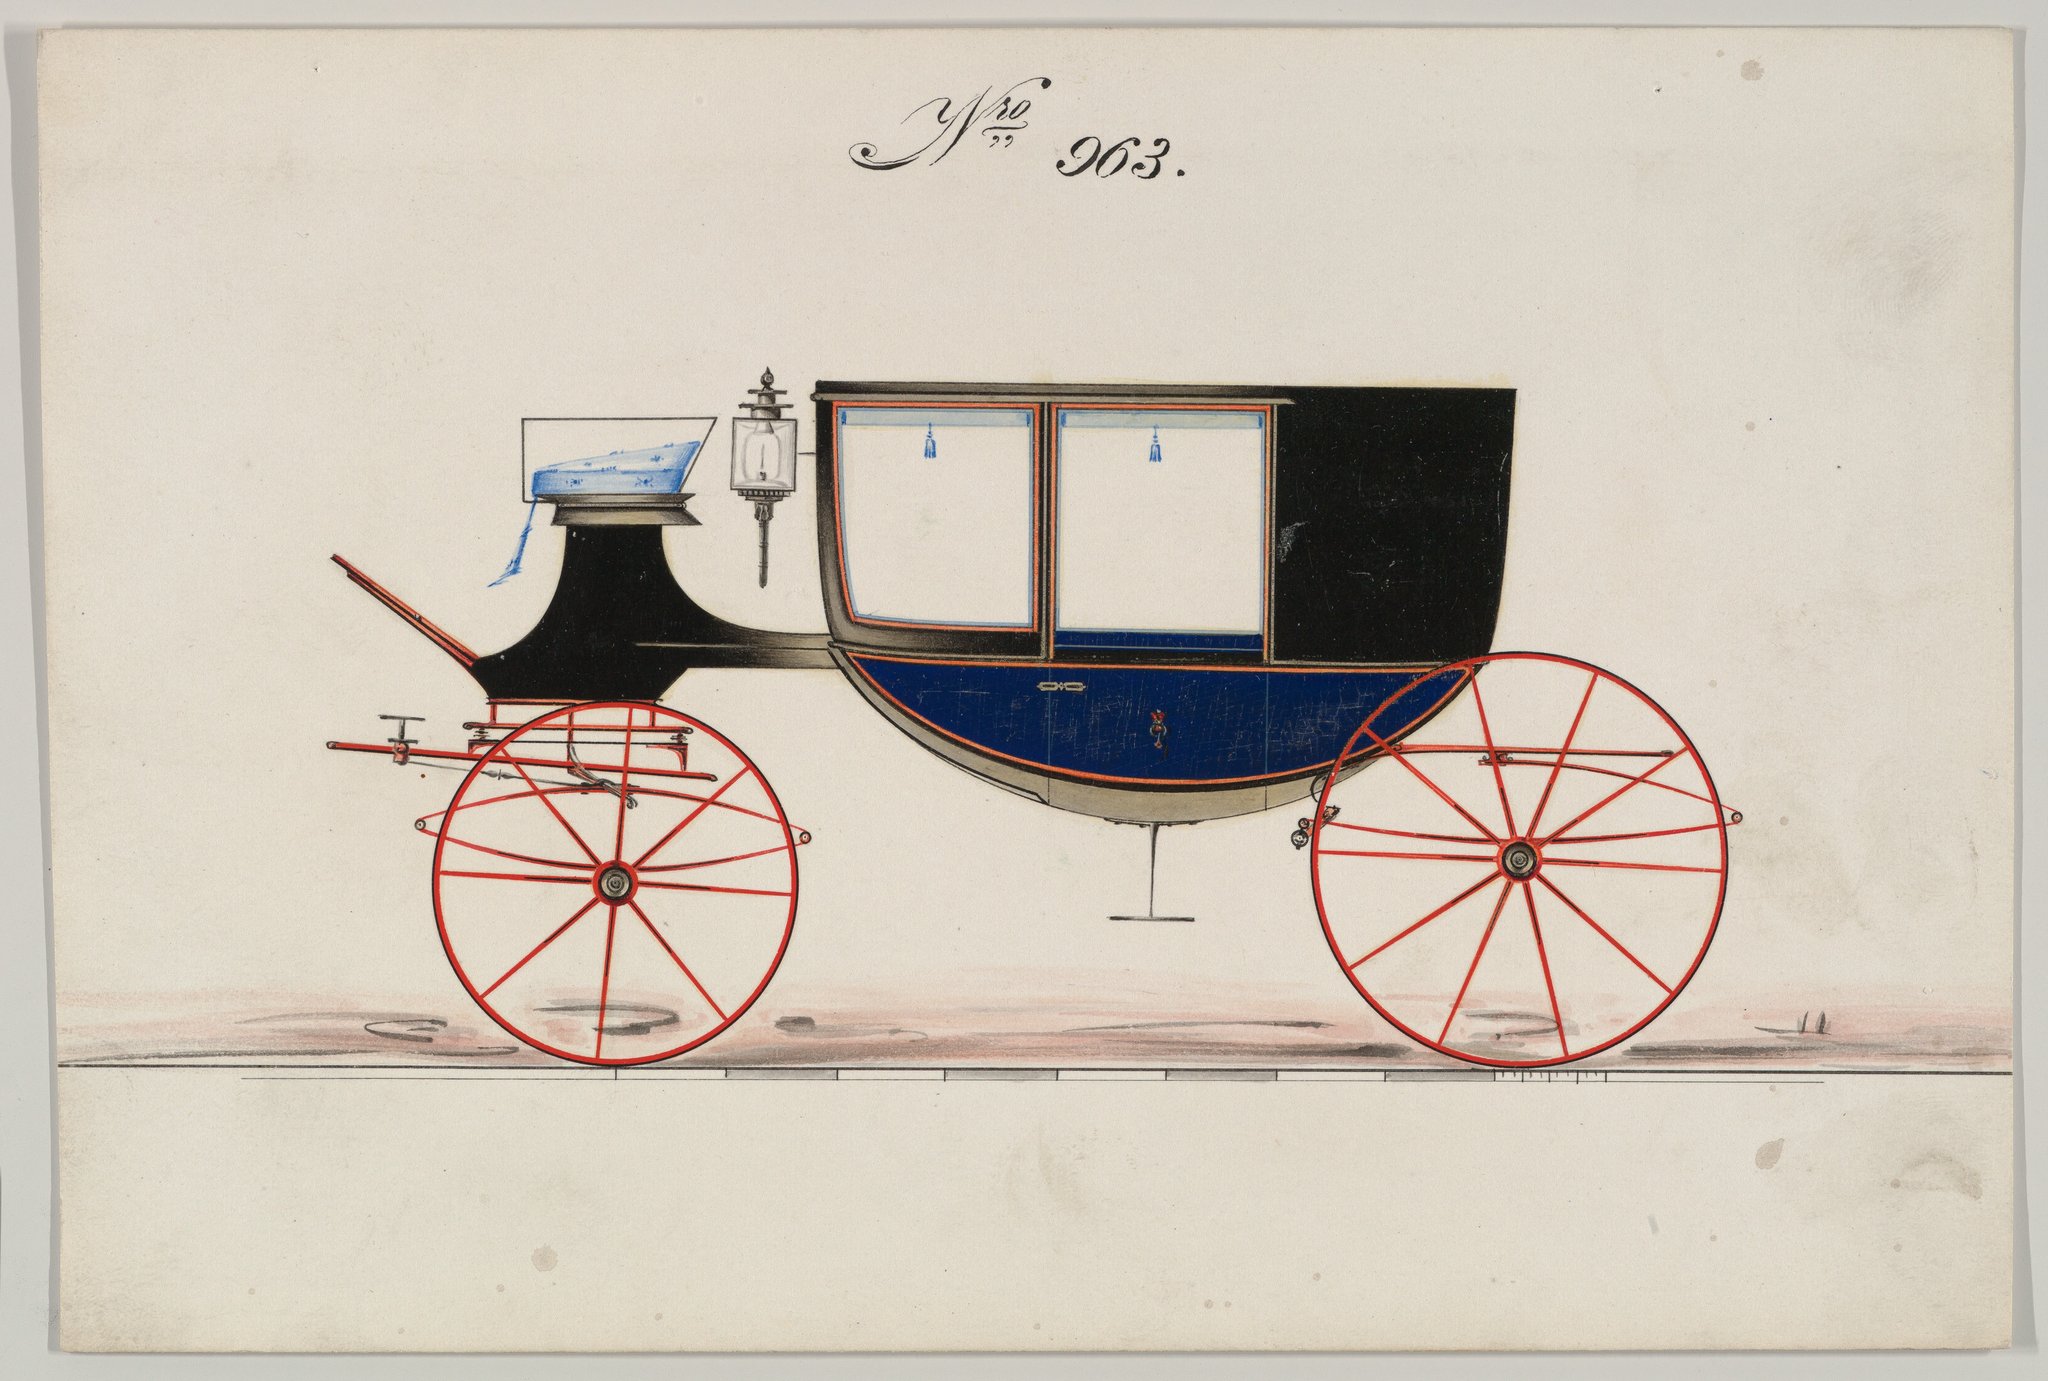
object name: drawing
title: Coach #963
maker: brewster & co.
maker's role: manufacturer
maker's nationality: american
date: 1870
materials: gouache, gum arabic, ink, watercolor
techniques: pen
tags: carriages